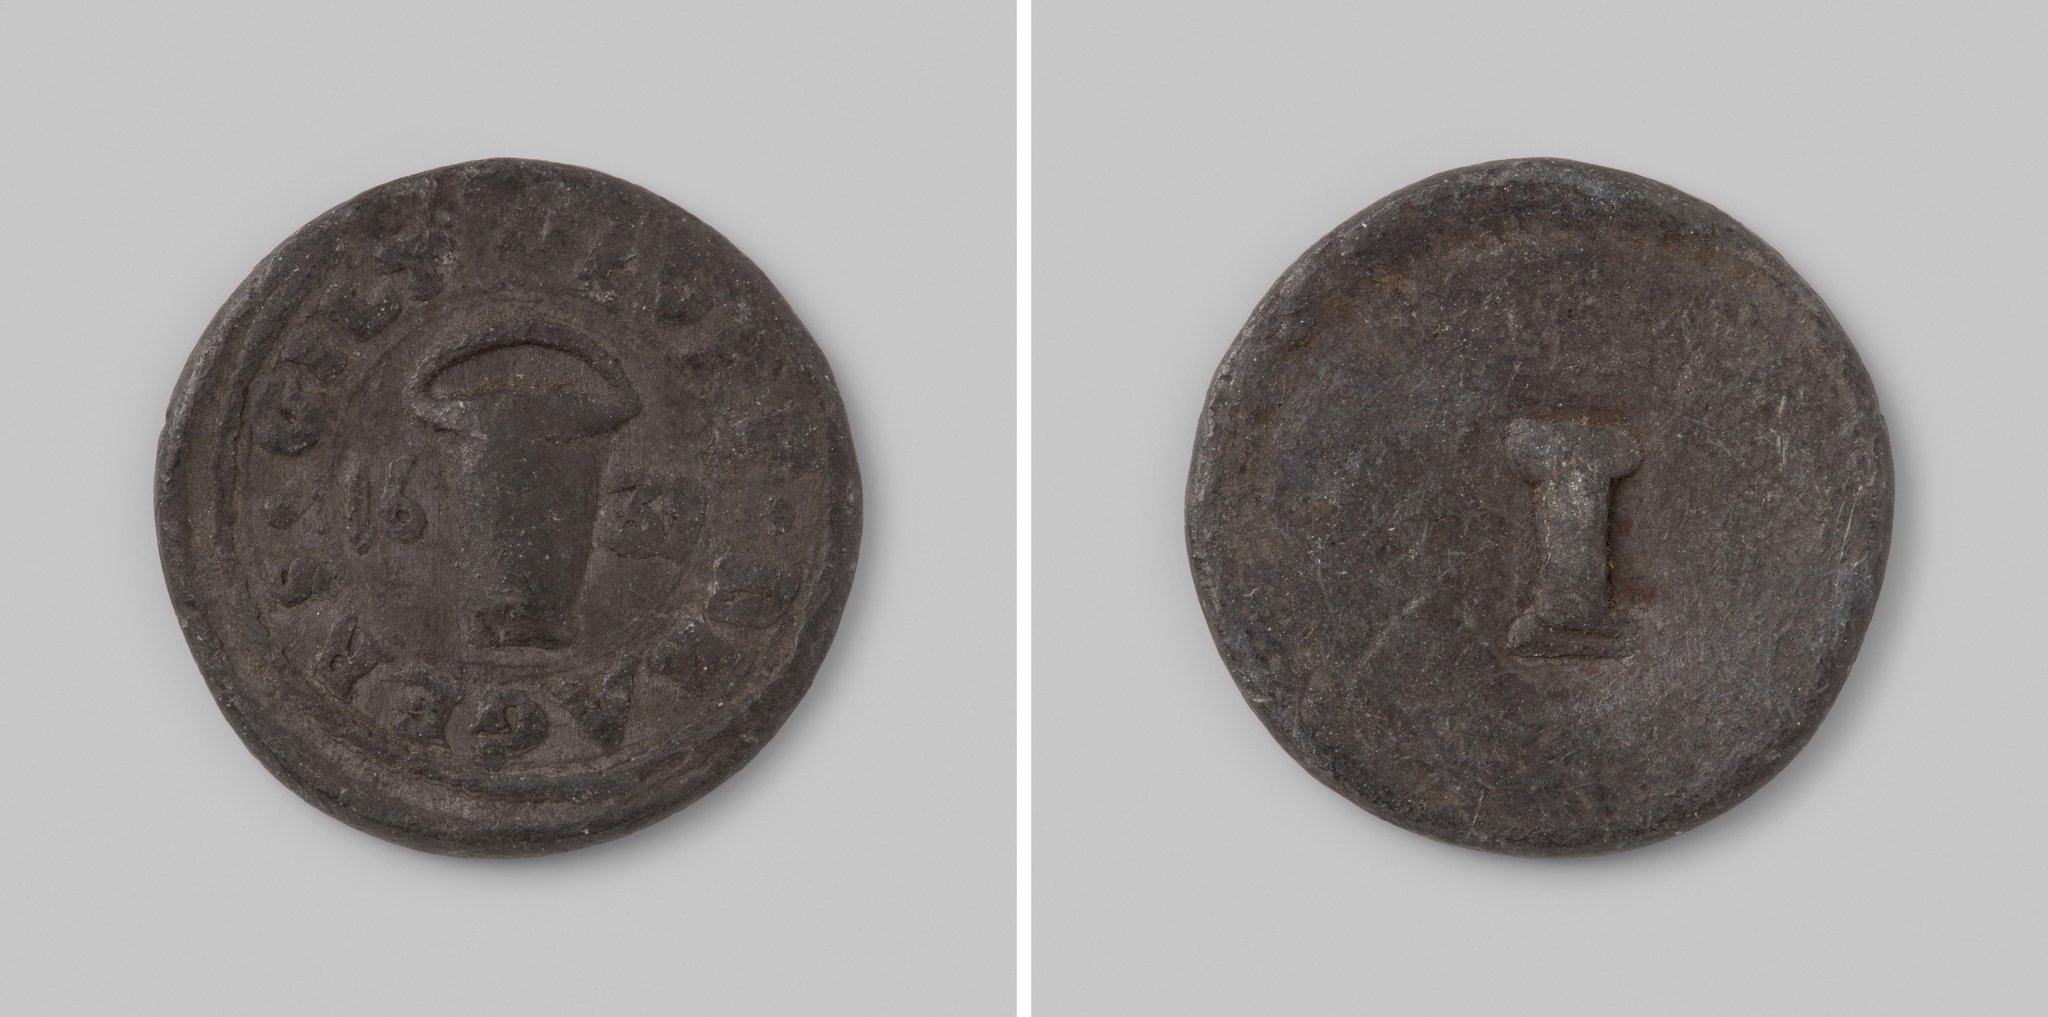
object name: history medal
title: Presentiepenning bij brand van het Turfdragersgilde te Amsterdam 1639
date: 1639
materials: lead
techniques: casting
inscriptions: circumscription: ‘TVRF.DRAGERS.GILT’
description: Gegoten loden penning, op de voorzijde een brandemmer tussen 16 en 39, op de keerzijde cijfer I.